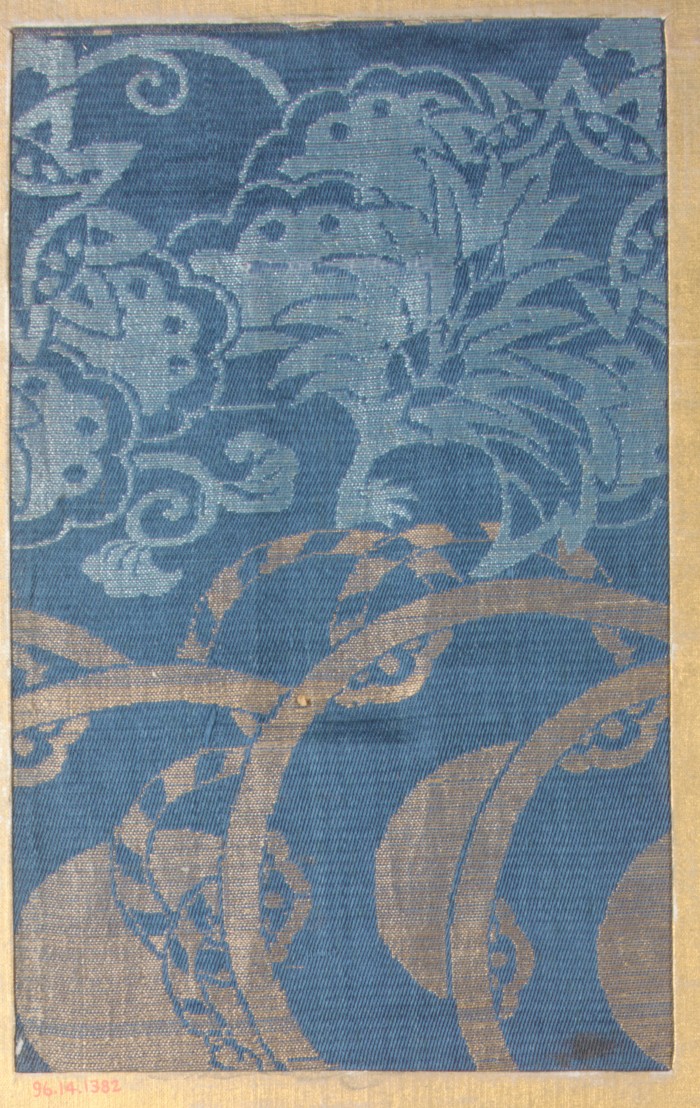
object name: piece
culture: japanese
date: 1701-1900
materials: silk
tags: flowers